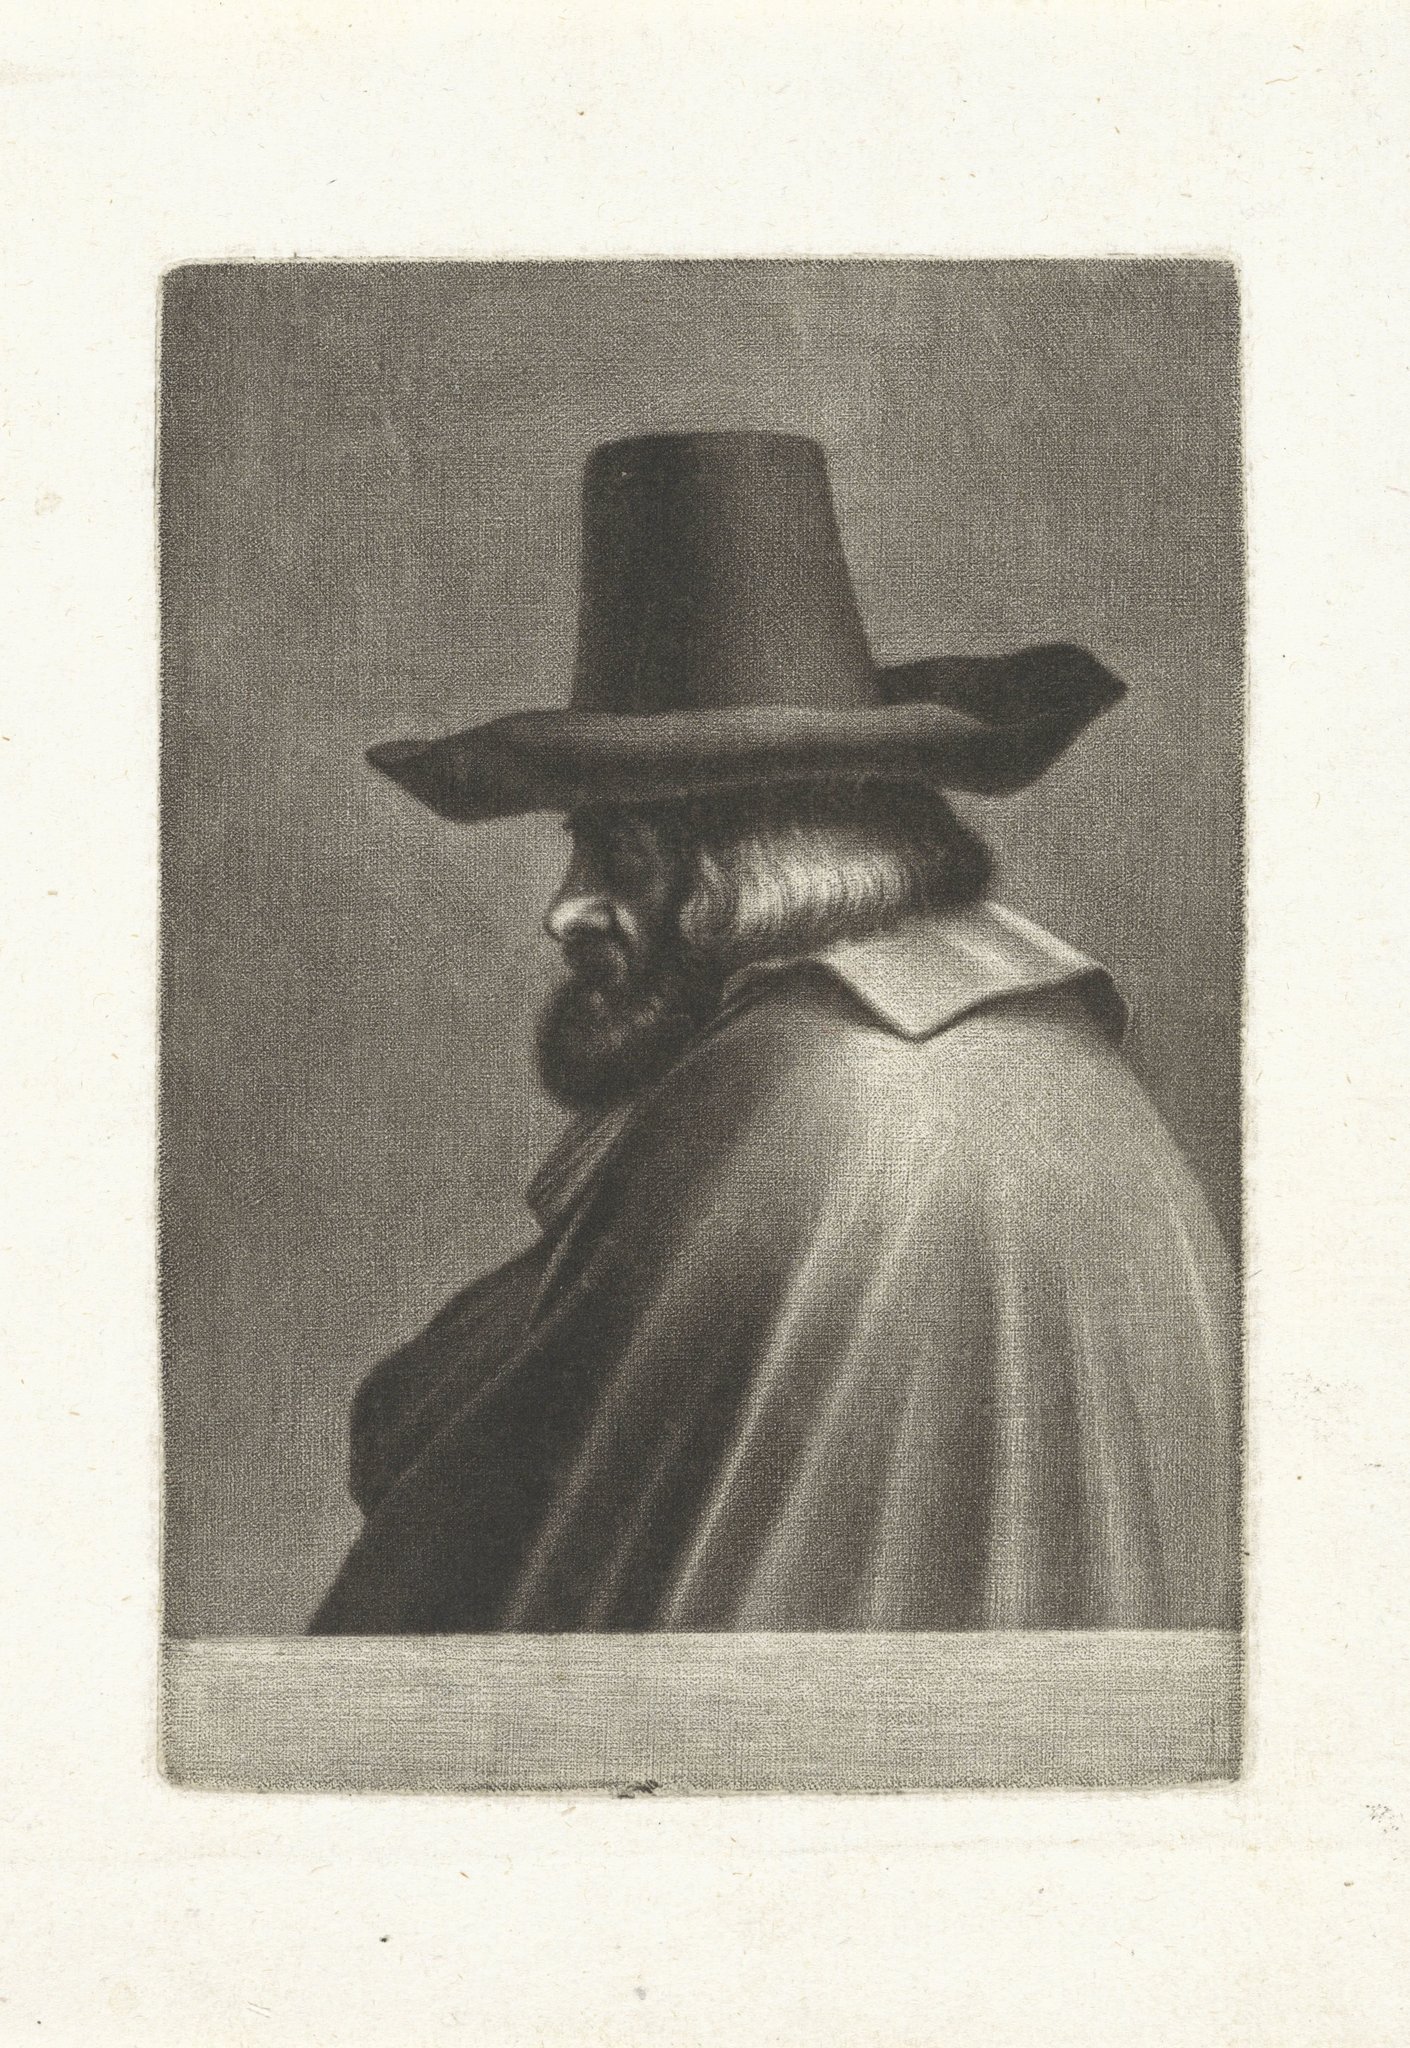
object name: print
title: Portret van Niclaus Weinstein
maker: johann friedrich leonard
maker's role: print maker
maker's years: 1633-1680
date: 1671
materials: paper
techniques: mezzotint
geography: prague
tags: head-gear: hat (+ men's clothes)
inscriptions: collector's mark: Lugt 2166